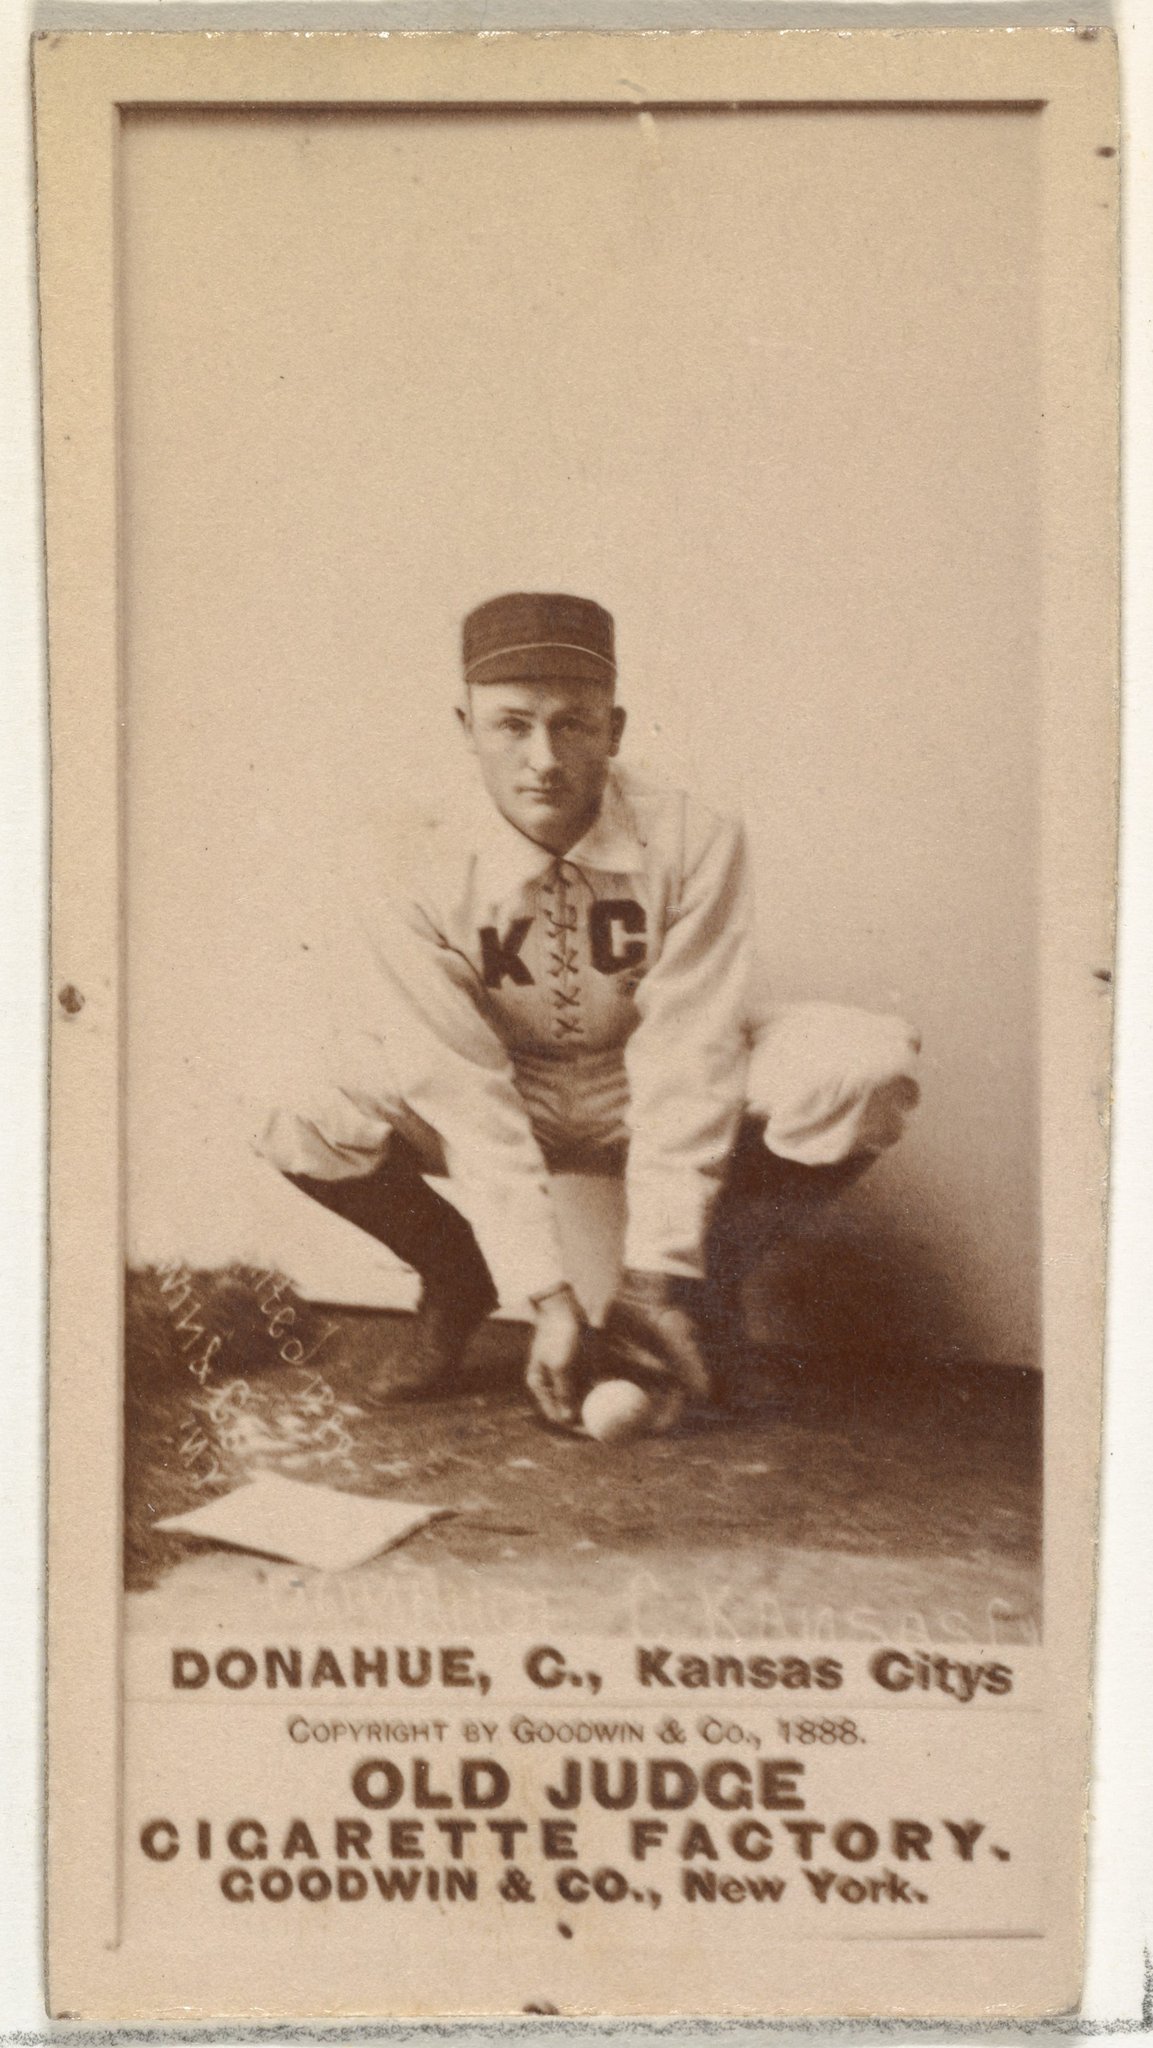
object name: baseball card, photograph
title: James Augustus "Jim" Donahue, Catcher, Kansas City Cowboys, from the Old Judge series (N172) for Old Judge Cigarettes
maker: goodwin & company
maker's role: publisher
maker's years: 1850-1950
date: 1888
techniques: albumen silver print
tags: men,portraits,baseball,athletes